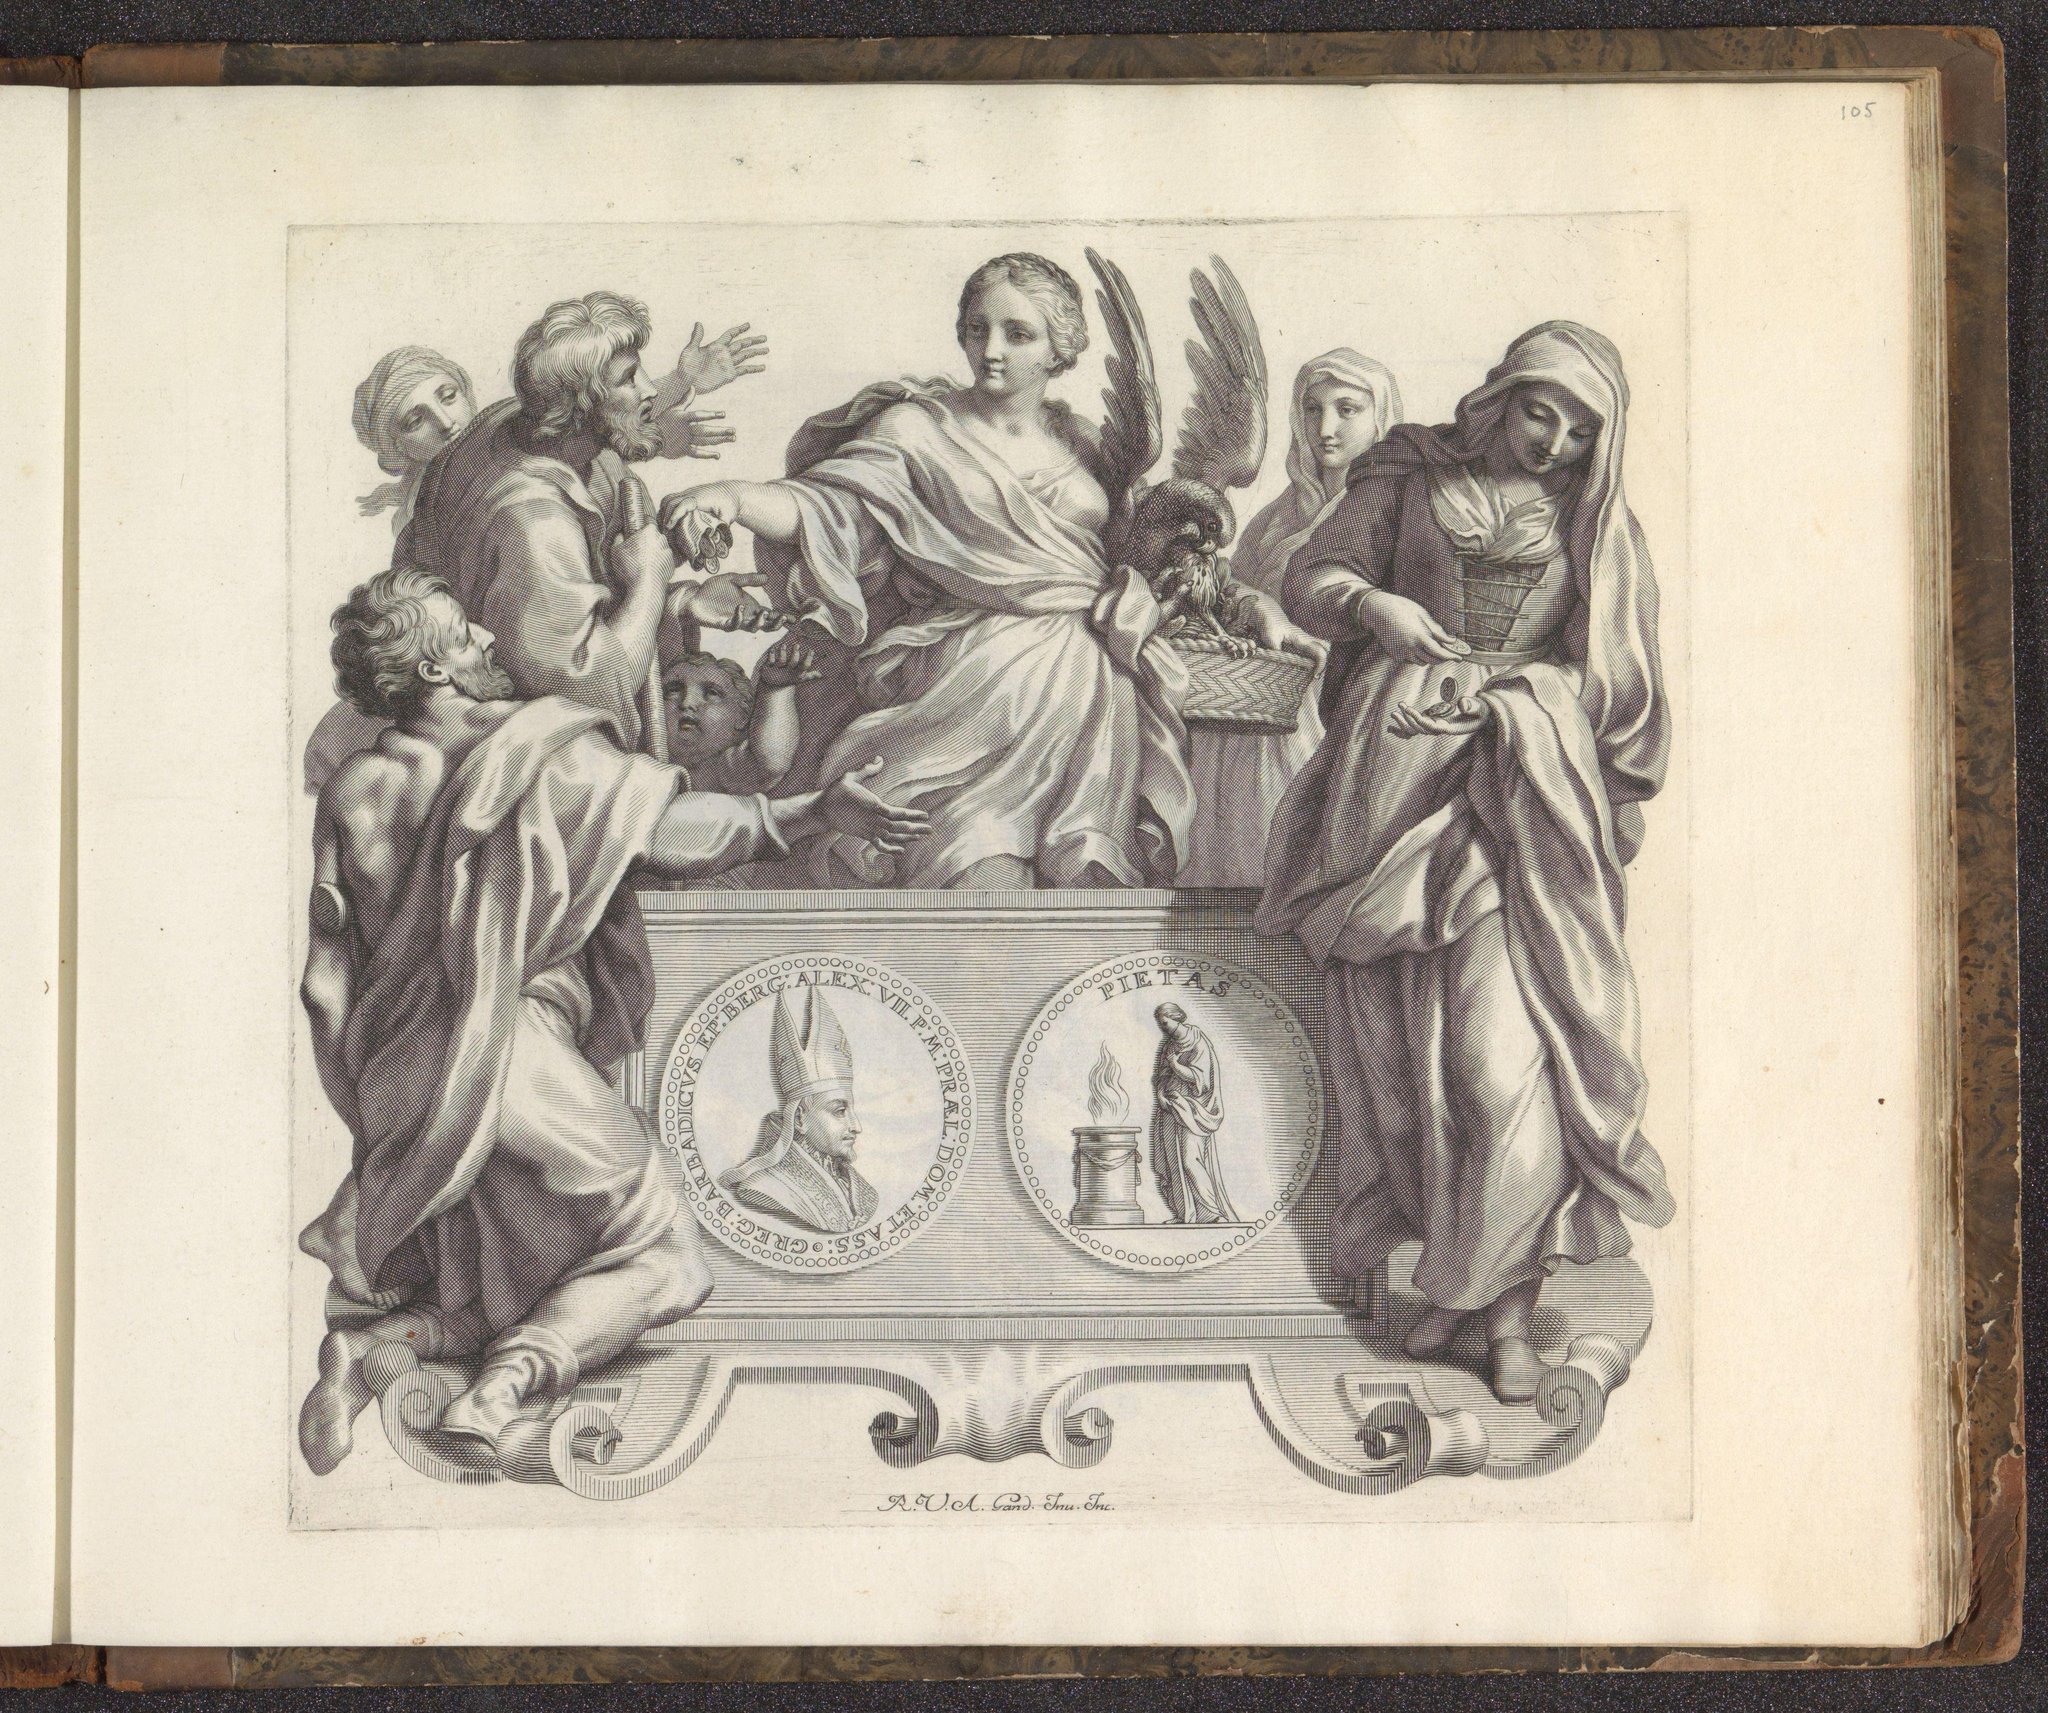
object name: album leaf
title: Numismata virorum illustrium ex Barbadica gente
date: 1673-1743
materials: paper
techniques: engraving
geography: rome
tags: venice, charity, 'caritas'; 'carità' (ripa) ~ one of the three theological virtues, symbols, allegories of peace, 'pax'; 'pace' (ripa), pietas as roman personification, restitution; 'restitutione' (ripa), mercy, compassion; 'compassione', 'misericordia' (ripa), water-birds: pelican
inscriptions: collector's mark: Lugt 2228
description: Voetstuk in de vorm van een cartouche. Daarop een medaillon met op de voorkant het portret van Gregorio Barbarigo. Hij draagt een bisschopsmijter op zijn hoofd. Op de achterkant staat Pietas bij een brandend altaar. De vrouw achter het voetstuk is de personificatie van Barmhartigheid of Compassie. Het betreft een vrouw met in haar linkerhand een nest met een pelikaan die zichzelf in de borst pikt. Met haar rechterhand deelt ze aalmoezen uit aan de armen. Rechts telt een vrouw haar geld. Ze hevelt het geld over van haar rechterhand in haar linkerhand. Zij is de personificatie van Vergoeding of Terruggave. De prent maakt deel uit van een album.